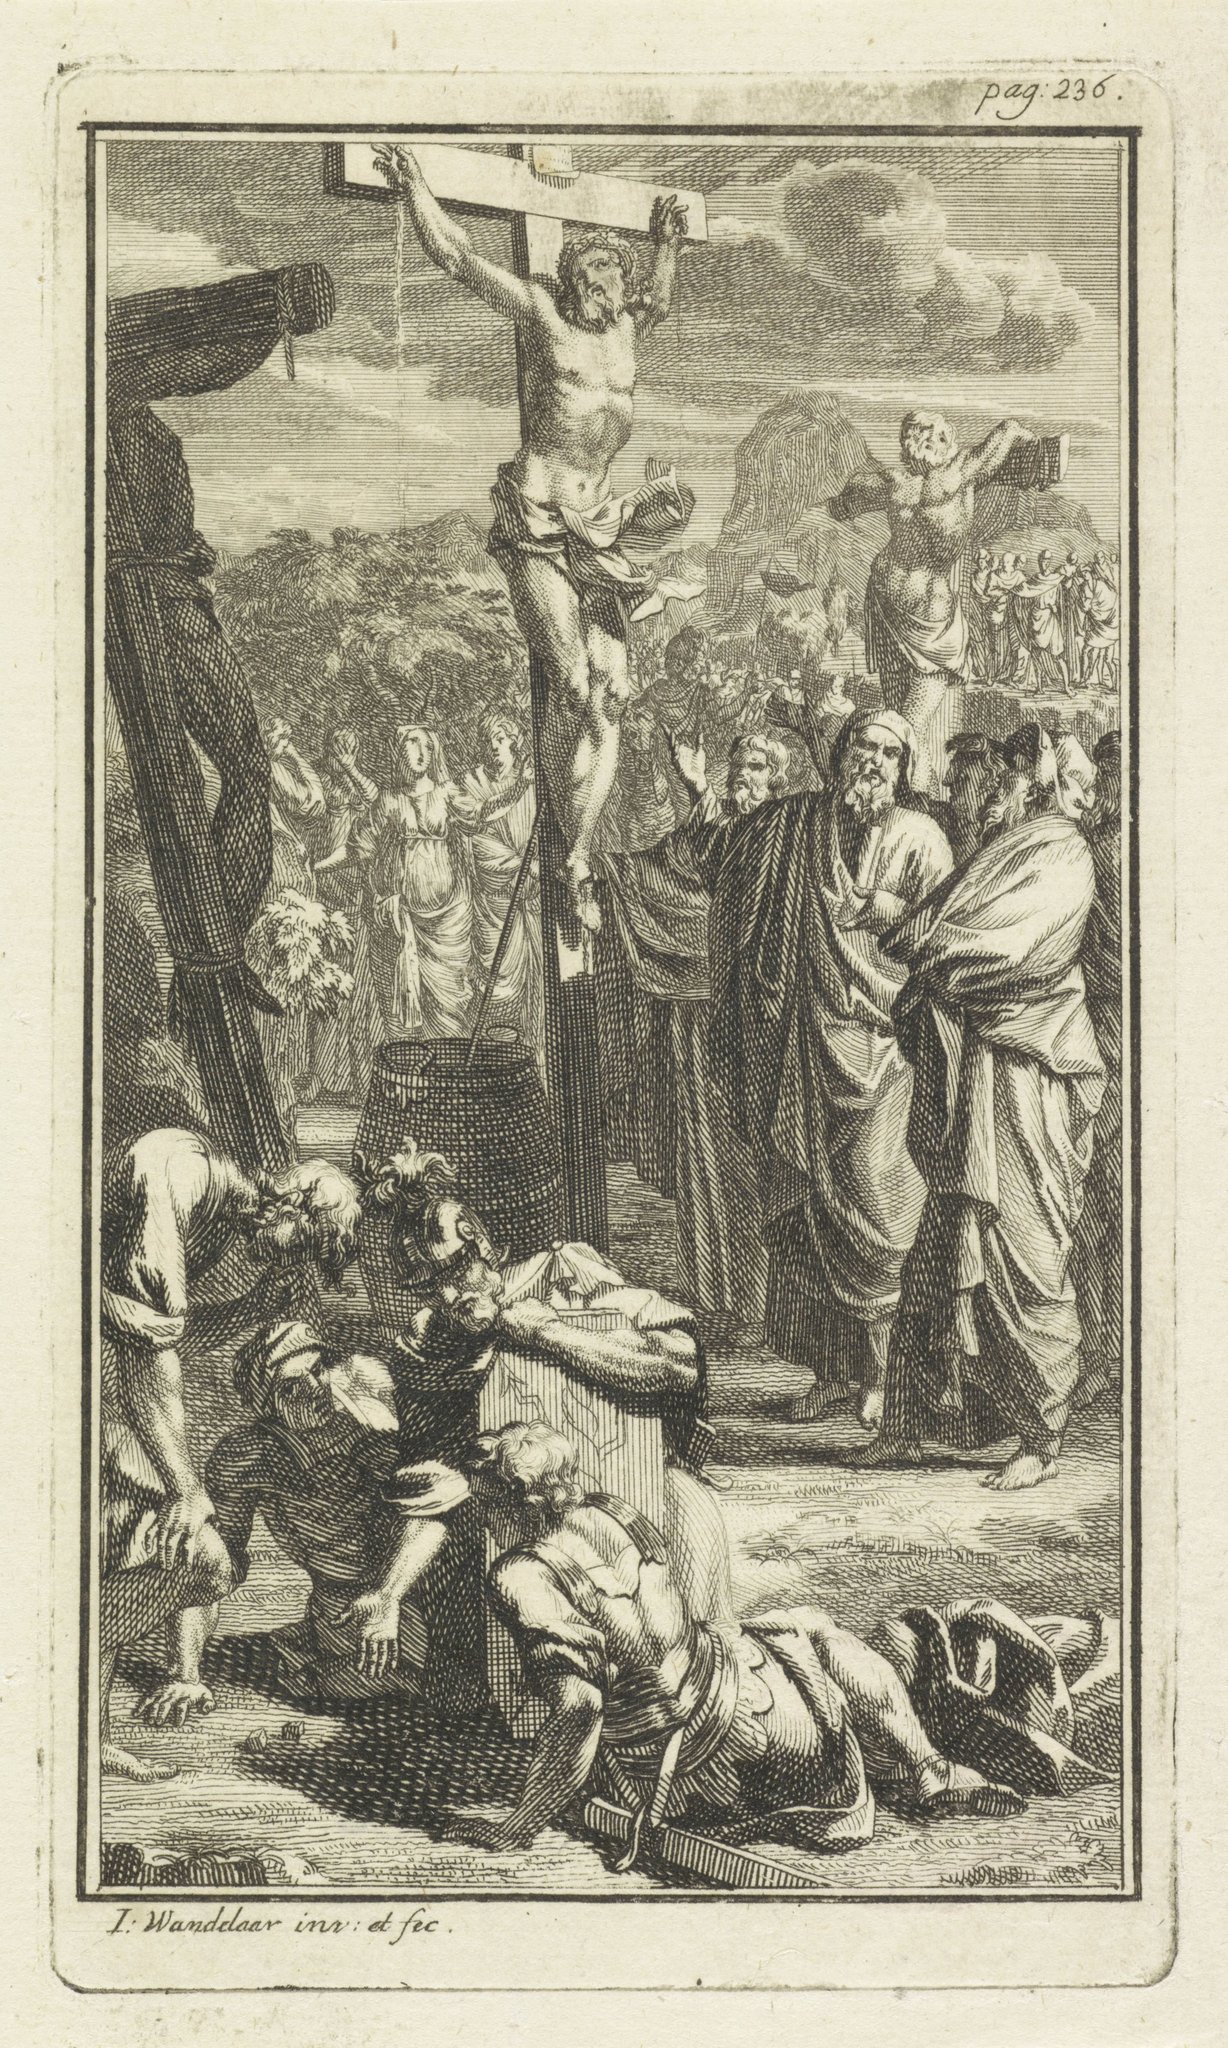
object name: book illustration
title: Kruisiging van Christus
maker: jan wandelaar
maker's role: draughtsman, print maker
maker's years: 1690-1759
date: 1725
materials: paper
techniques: engraving, etching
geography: northern netherlands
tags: crucified christ with other persons, soldiers throwing dice for christ's seamless garment ~ christ's death on the cross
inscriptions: collector's mark: Lugt 240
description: De prent is als boekillustratie gebruikt in: Hoek, Kornelis van. De vernederde en verhoogde Kristus, behelzende 's Heylands geboorte, leven, lyden, sterven, en begravenis, opstandinge, hemelvaart, zittinge aan Gods regterhand, en komst ten oordeel. Amsterdam: Jacob ter Beek, 1725